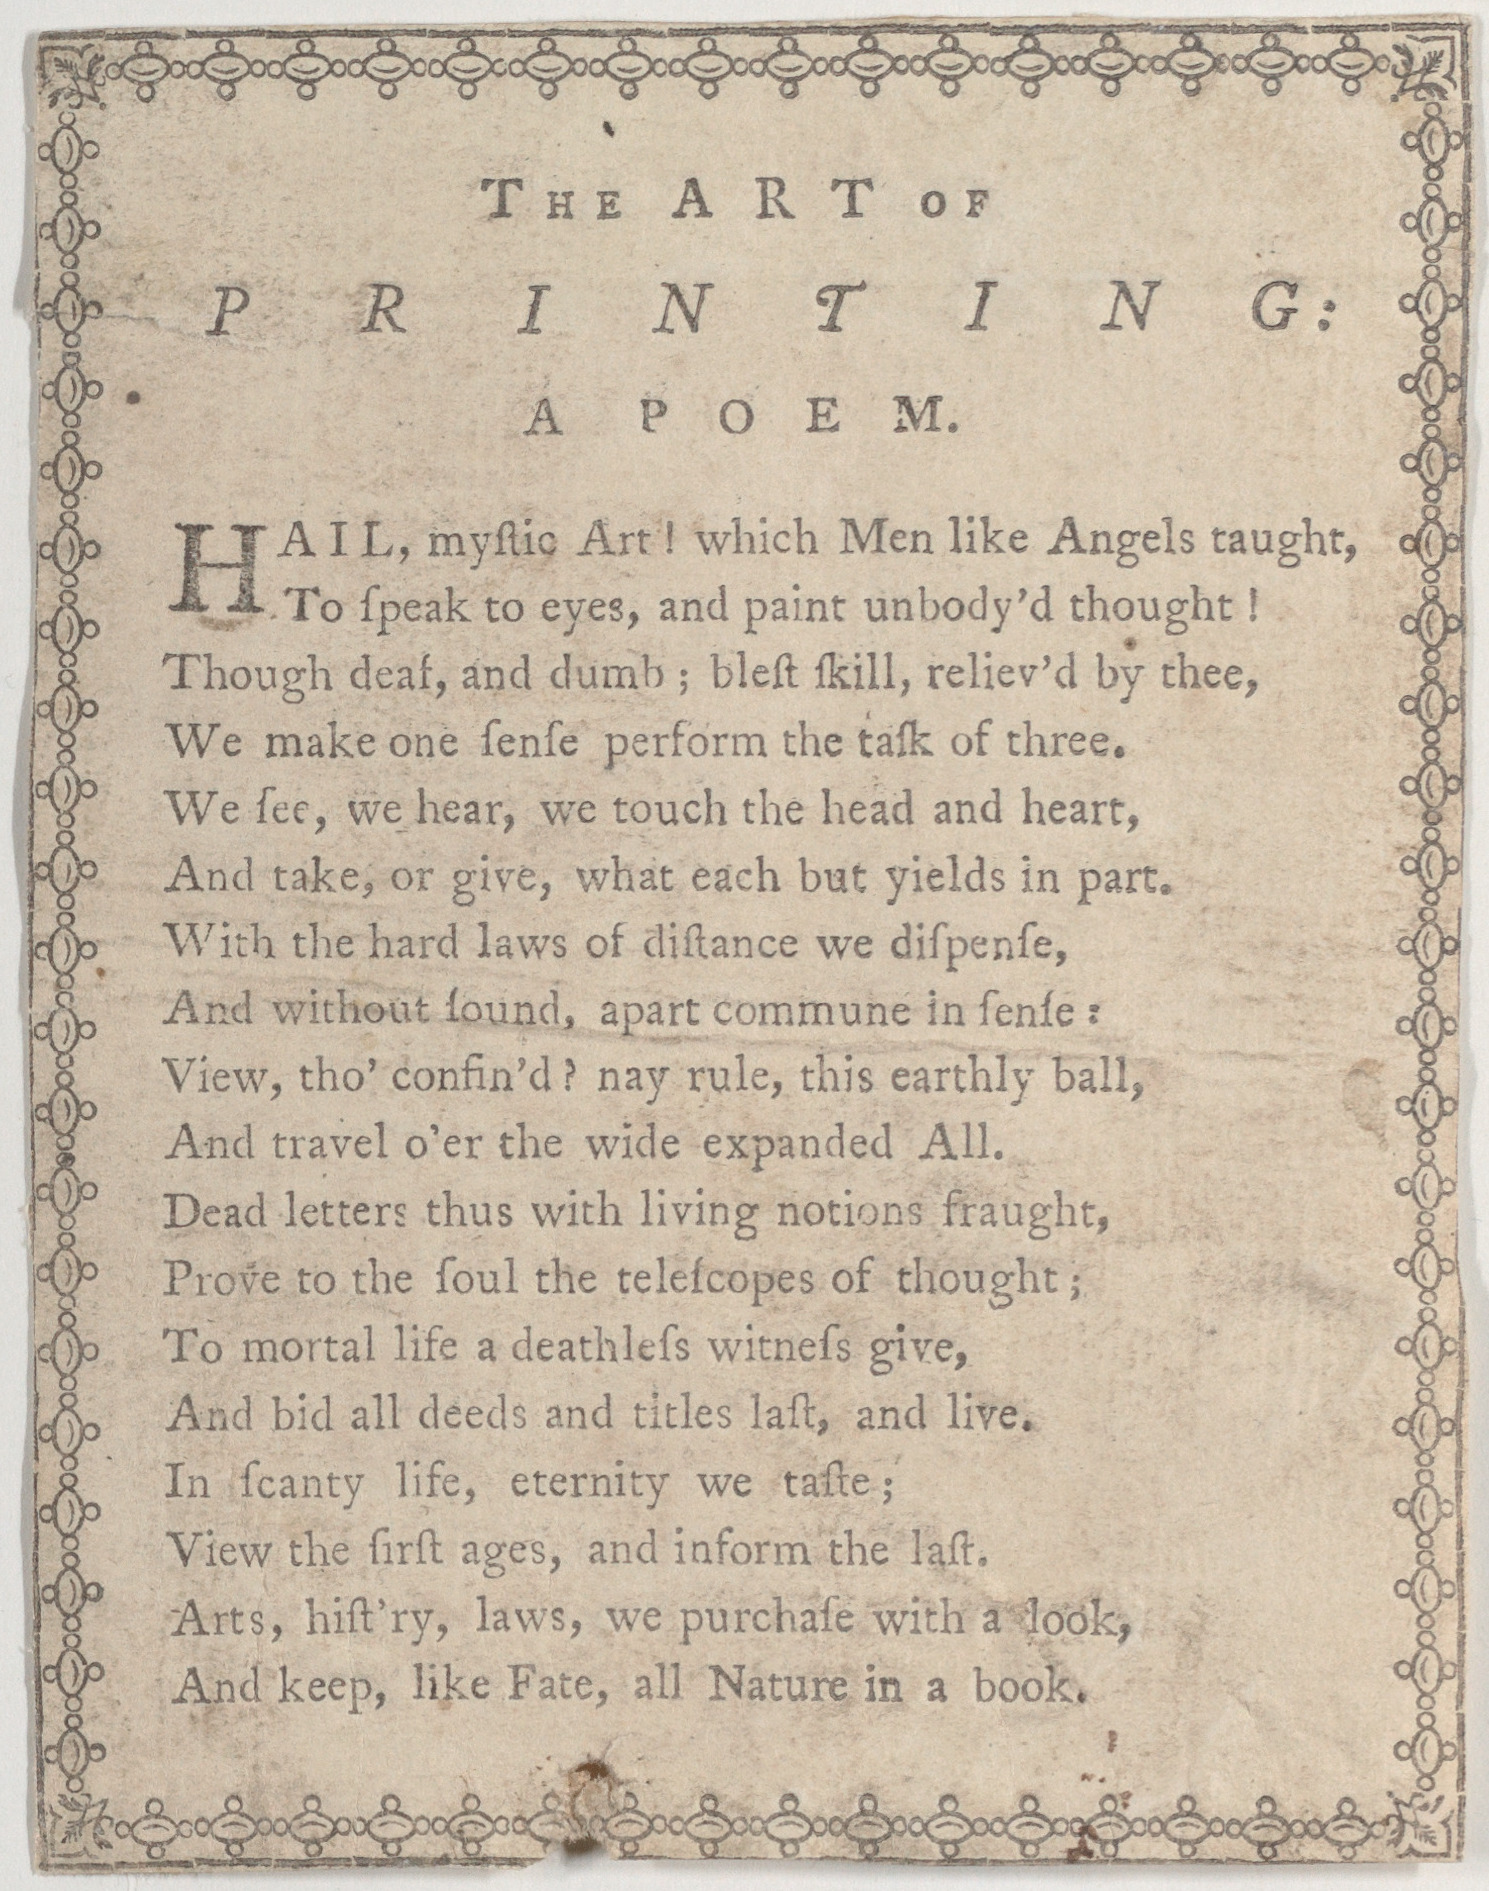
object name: print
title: The Art of Printing: A Poem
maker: anonymous, british, 19th century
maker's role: artist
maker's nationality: british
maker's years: 1800-1900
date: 1801-1900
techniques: letterpress